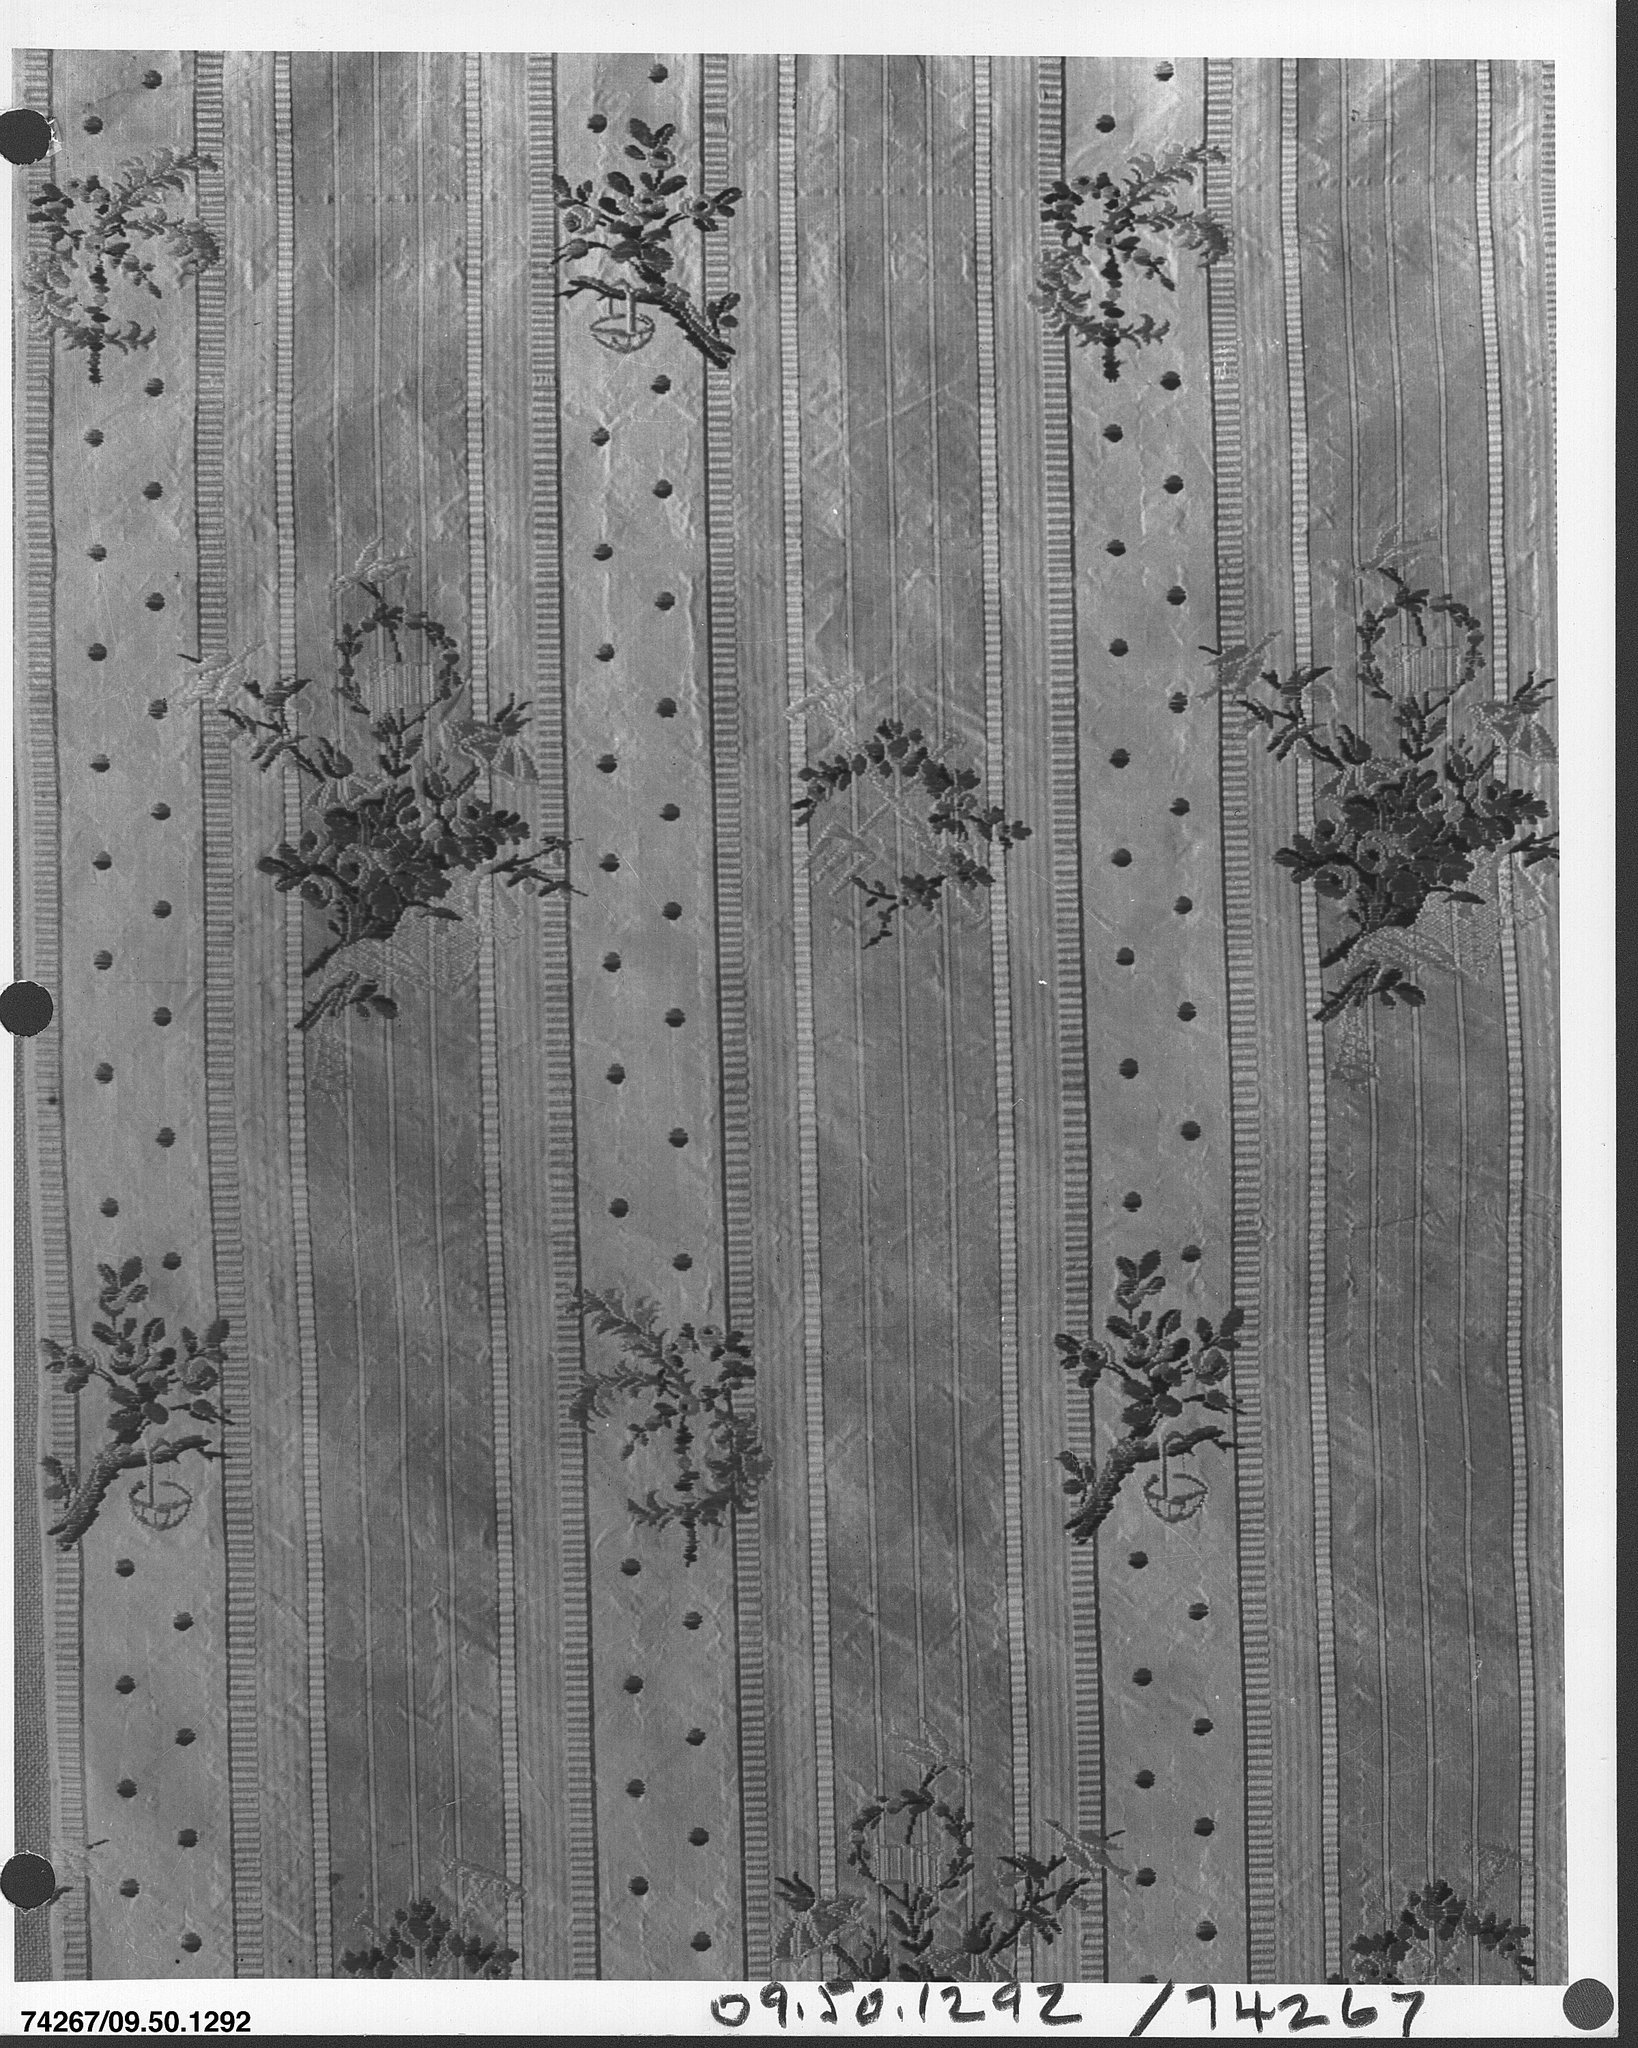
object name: piece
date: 1767-1800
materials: silk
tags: flowers,leaves